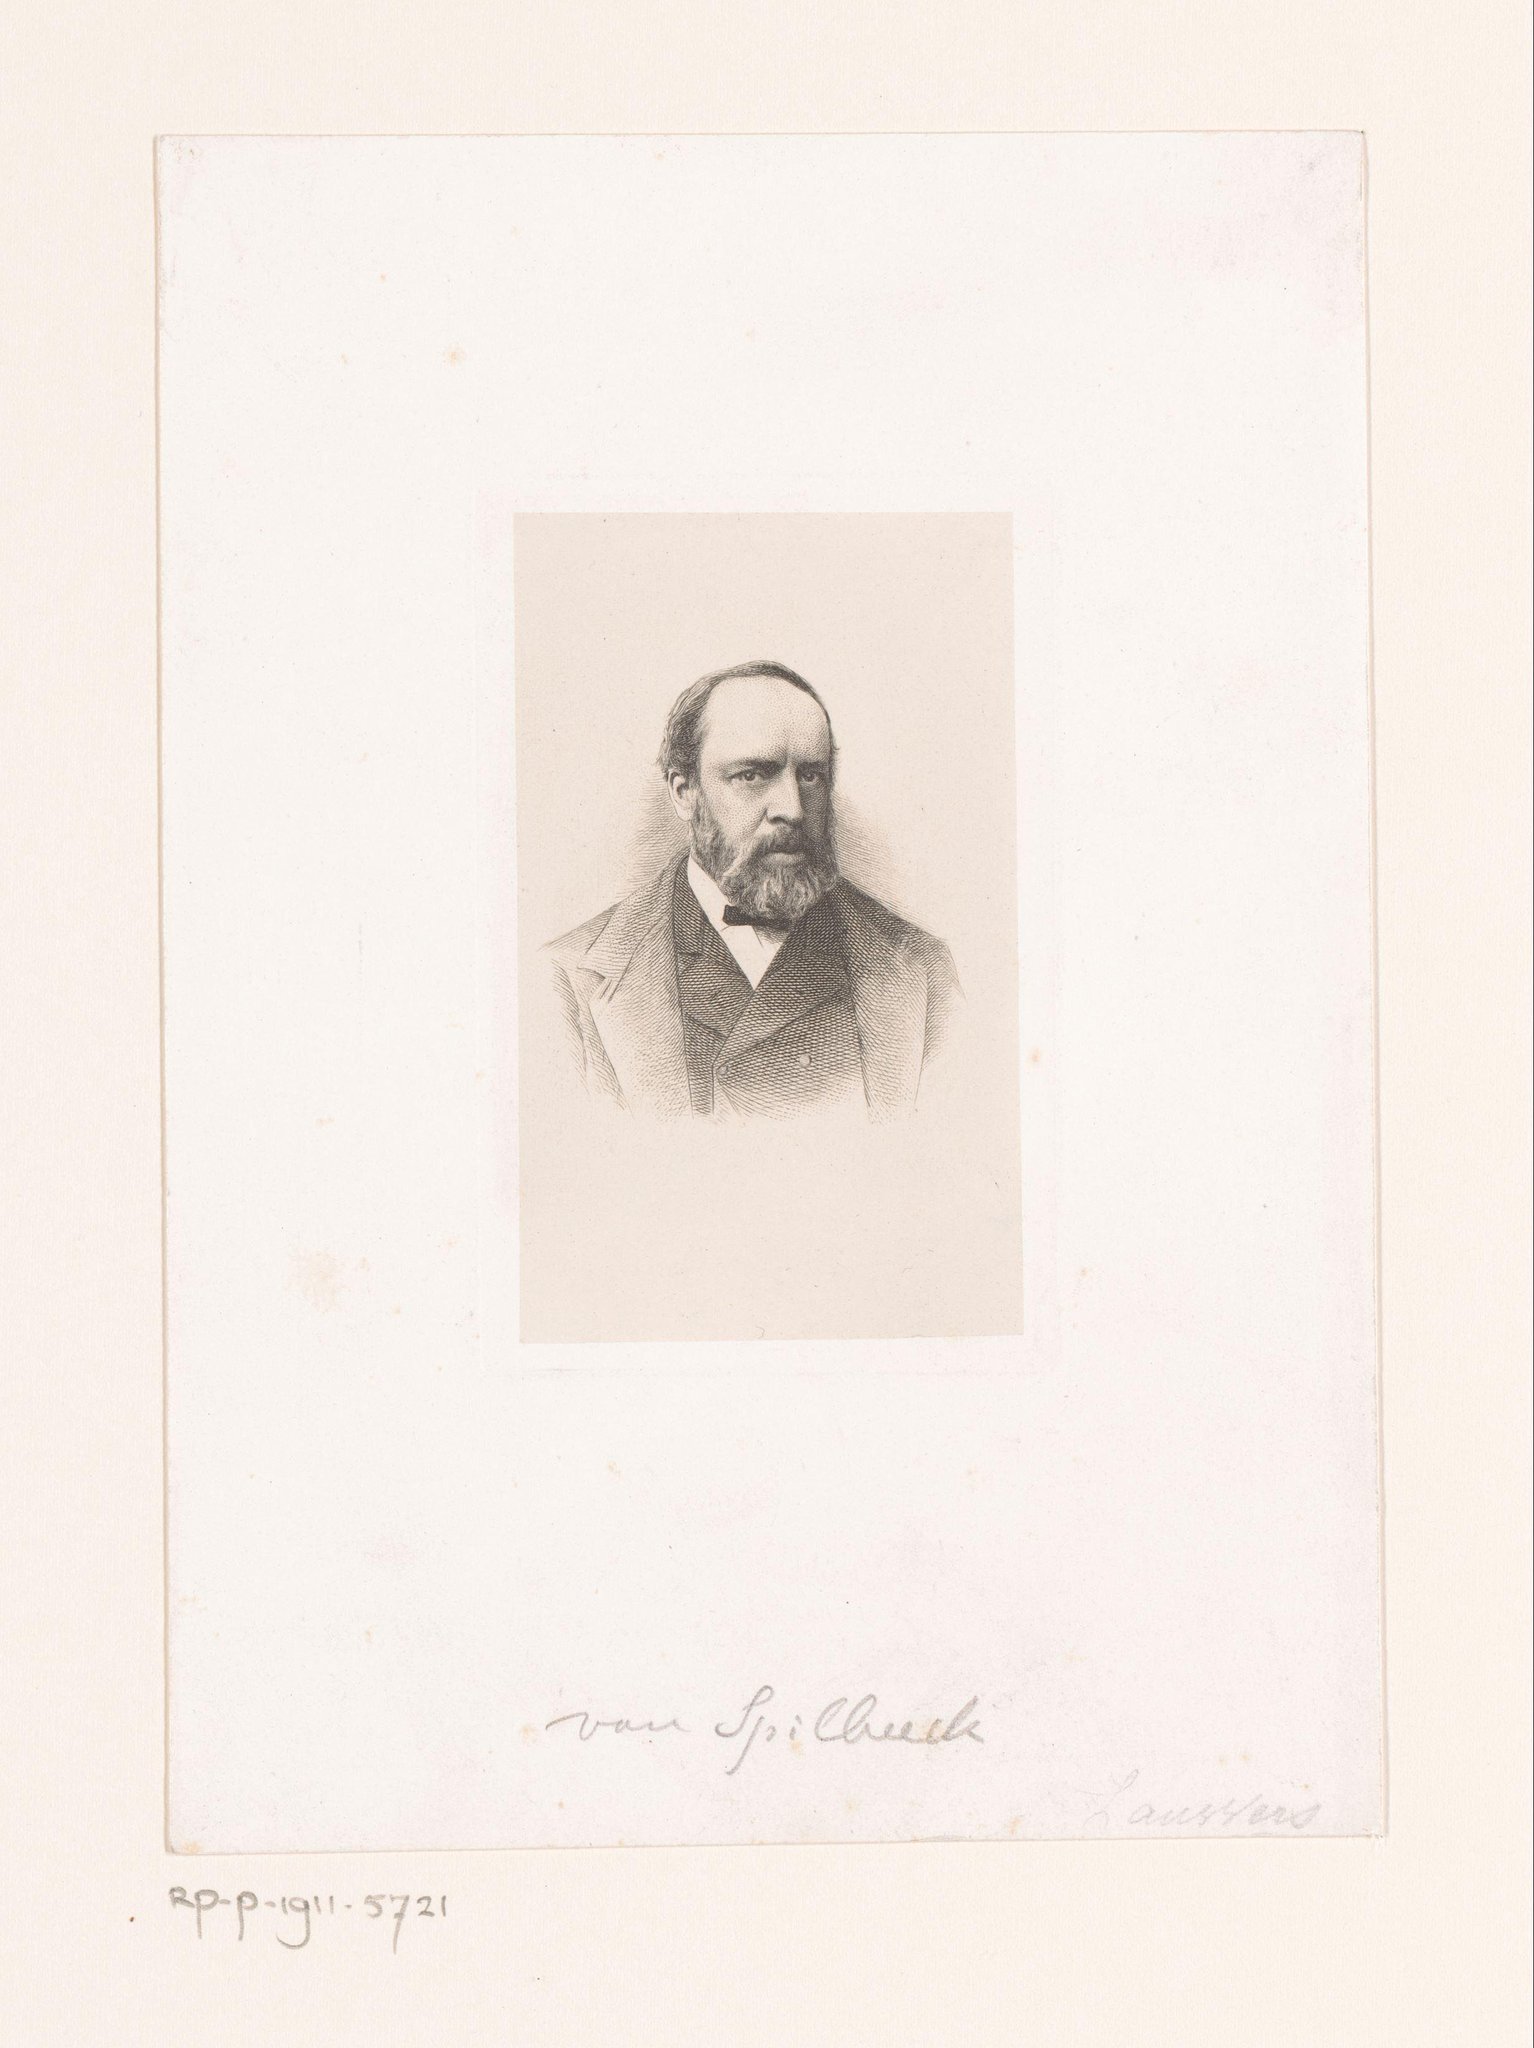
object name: print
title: Portret van een onbekende man, mogelijk Van Spilbeeck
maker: frans lauwers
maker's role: print maker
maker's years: 1854-1931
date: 1864-1911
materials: paper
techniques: etching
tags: historical persons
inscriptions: collector's mark: Lugt 2228